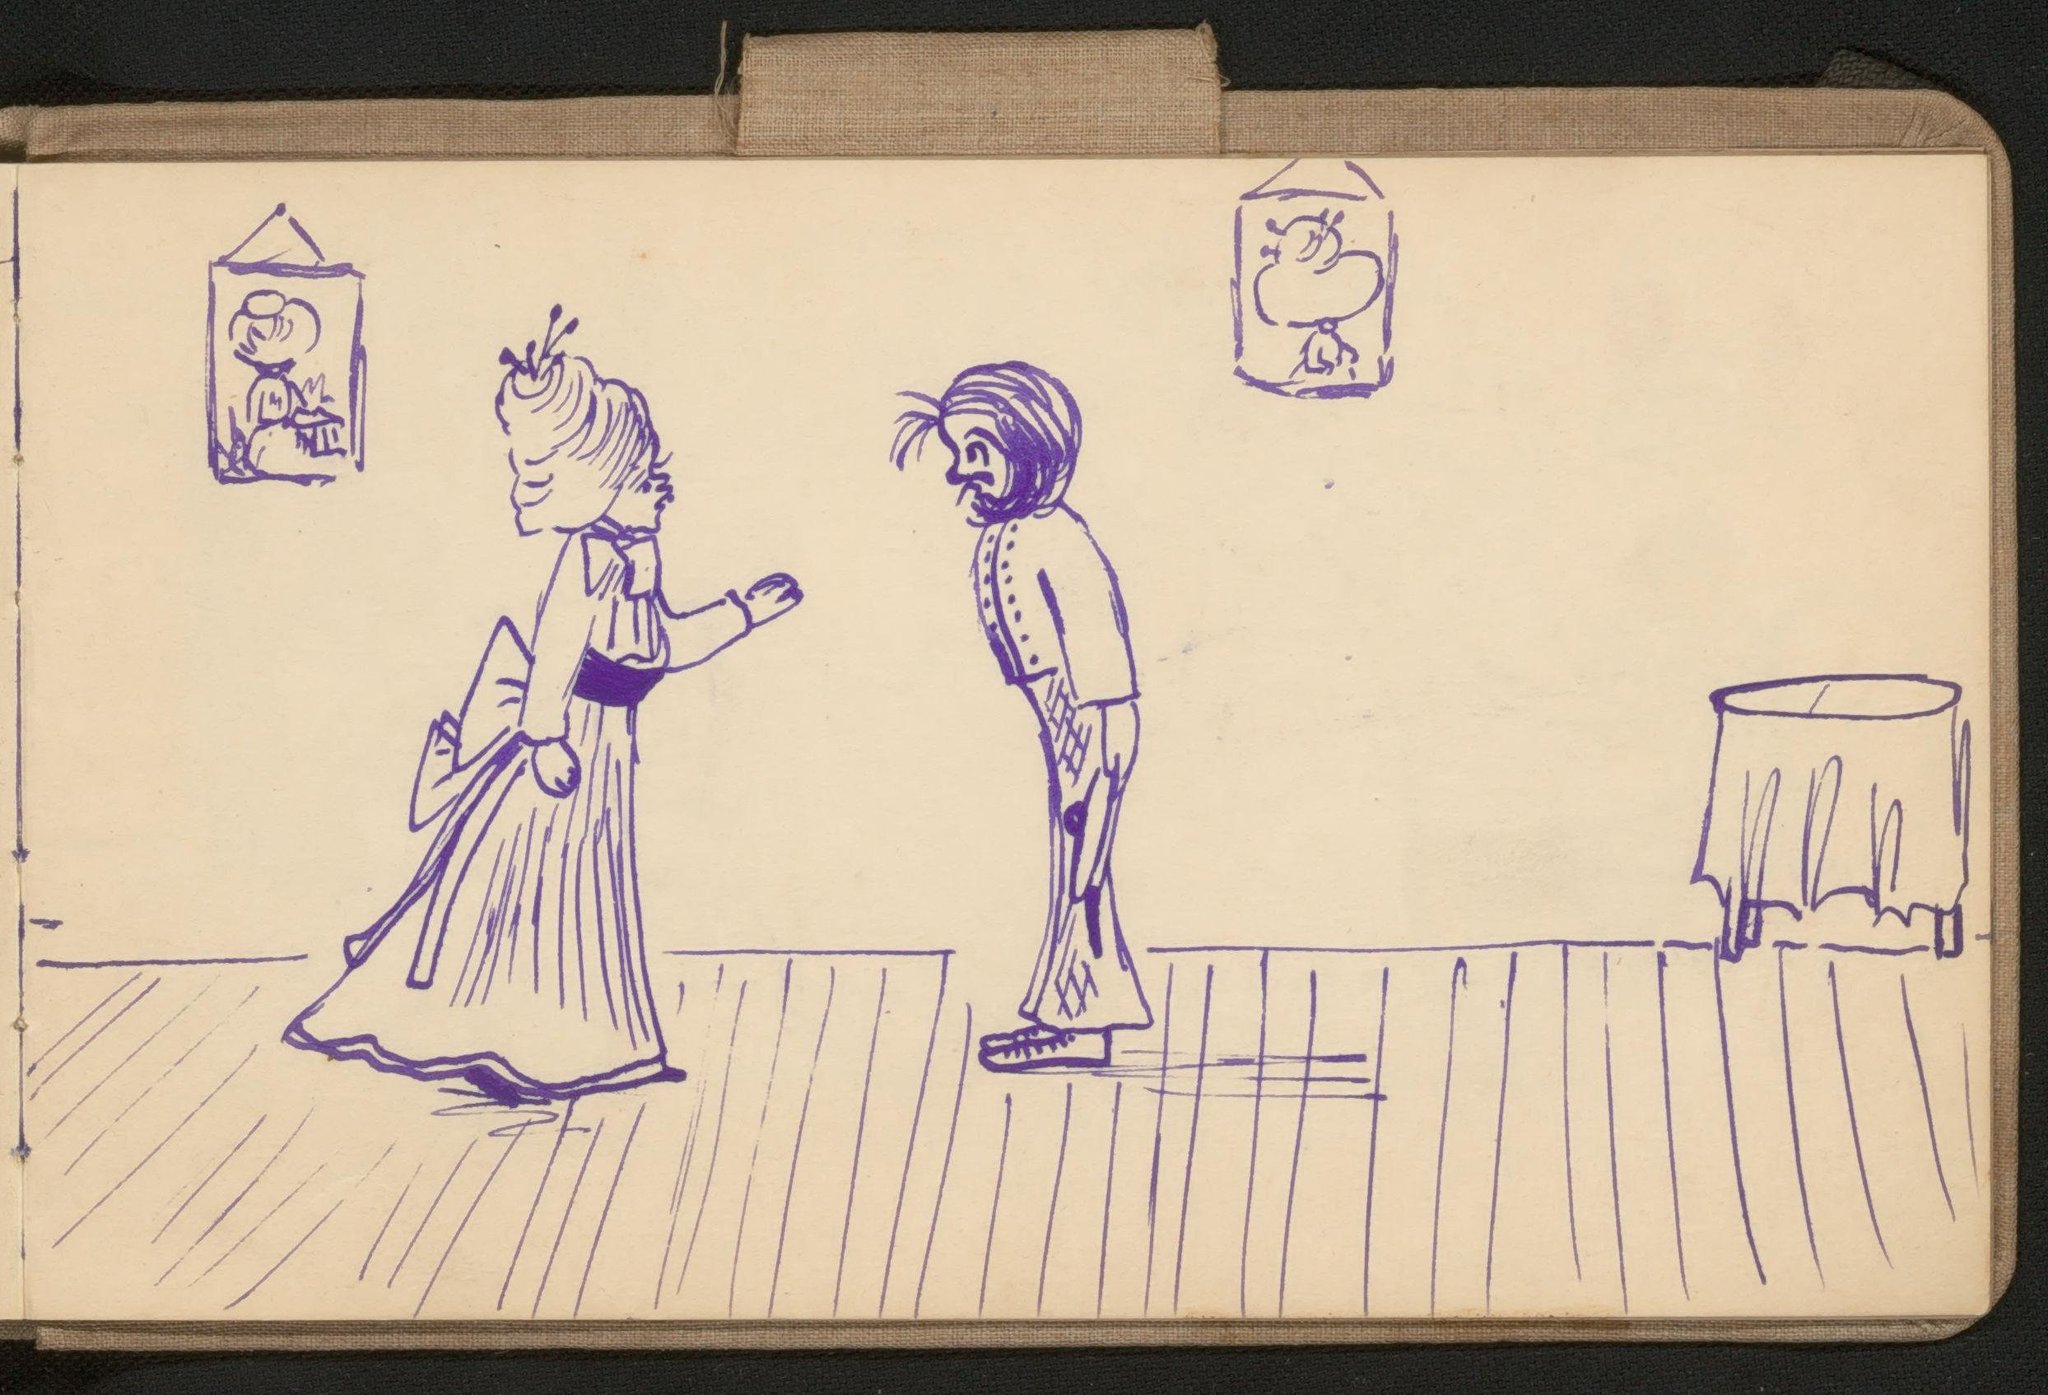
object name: sketchbook leaf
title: Ma en Pa sprekend met elkaar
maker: Anonymous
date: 1875-1920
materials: ink, paper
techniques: pen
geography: netherlands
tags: living-room, parlour, sitting-room, pregnant woman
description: Ma en Pa sprekend met elkaar, mogelijk vertelt ze hem dat ze een kind verwacht. Onderdeel van het schetsboek met humoristische tekeningen over het leven van een 'famille nombreuse'. Onderwerpsrubrieken binnen de Atlas Zeden en Gewoonten: Zeden en Gewoonten in Engeren Zin, Des menschen beging, midden en einde, Kinderleven.